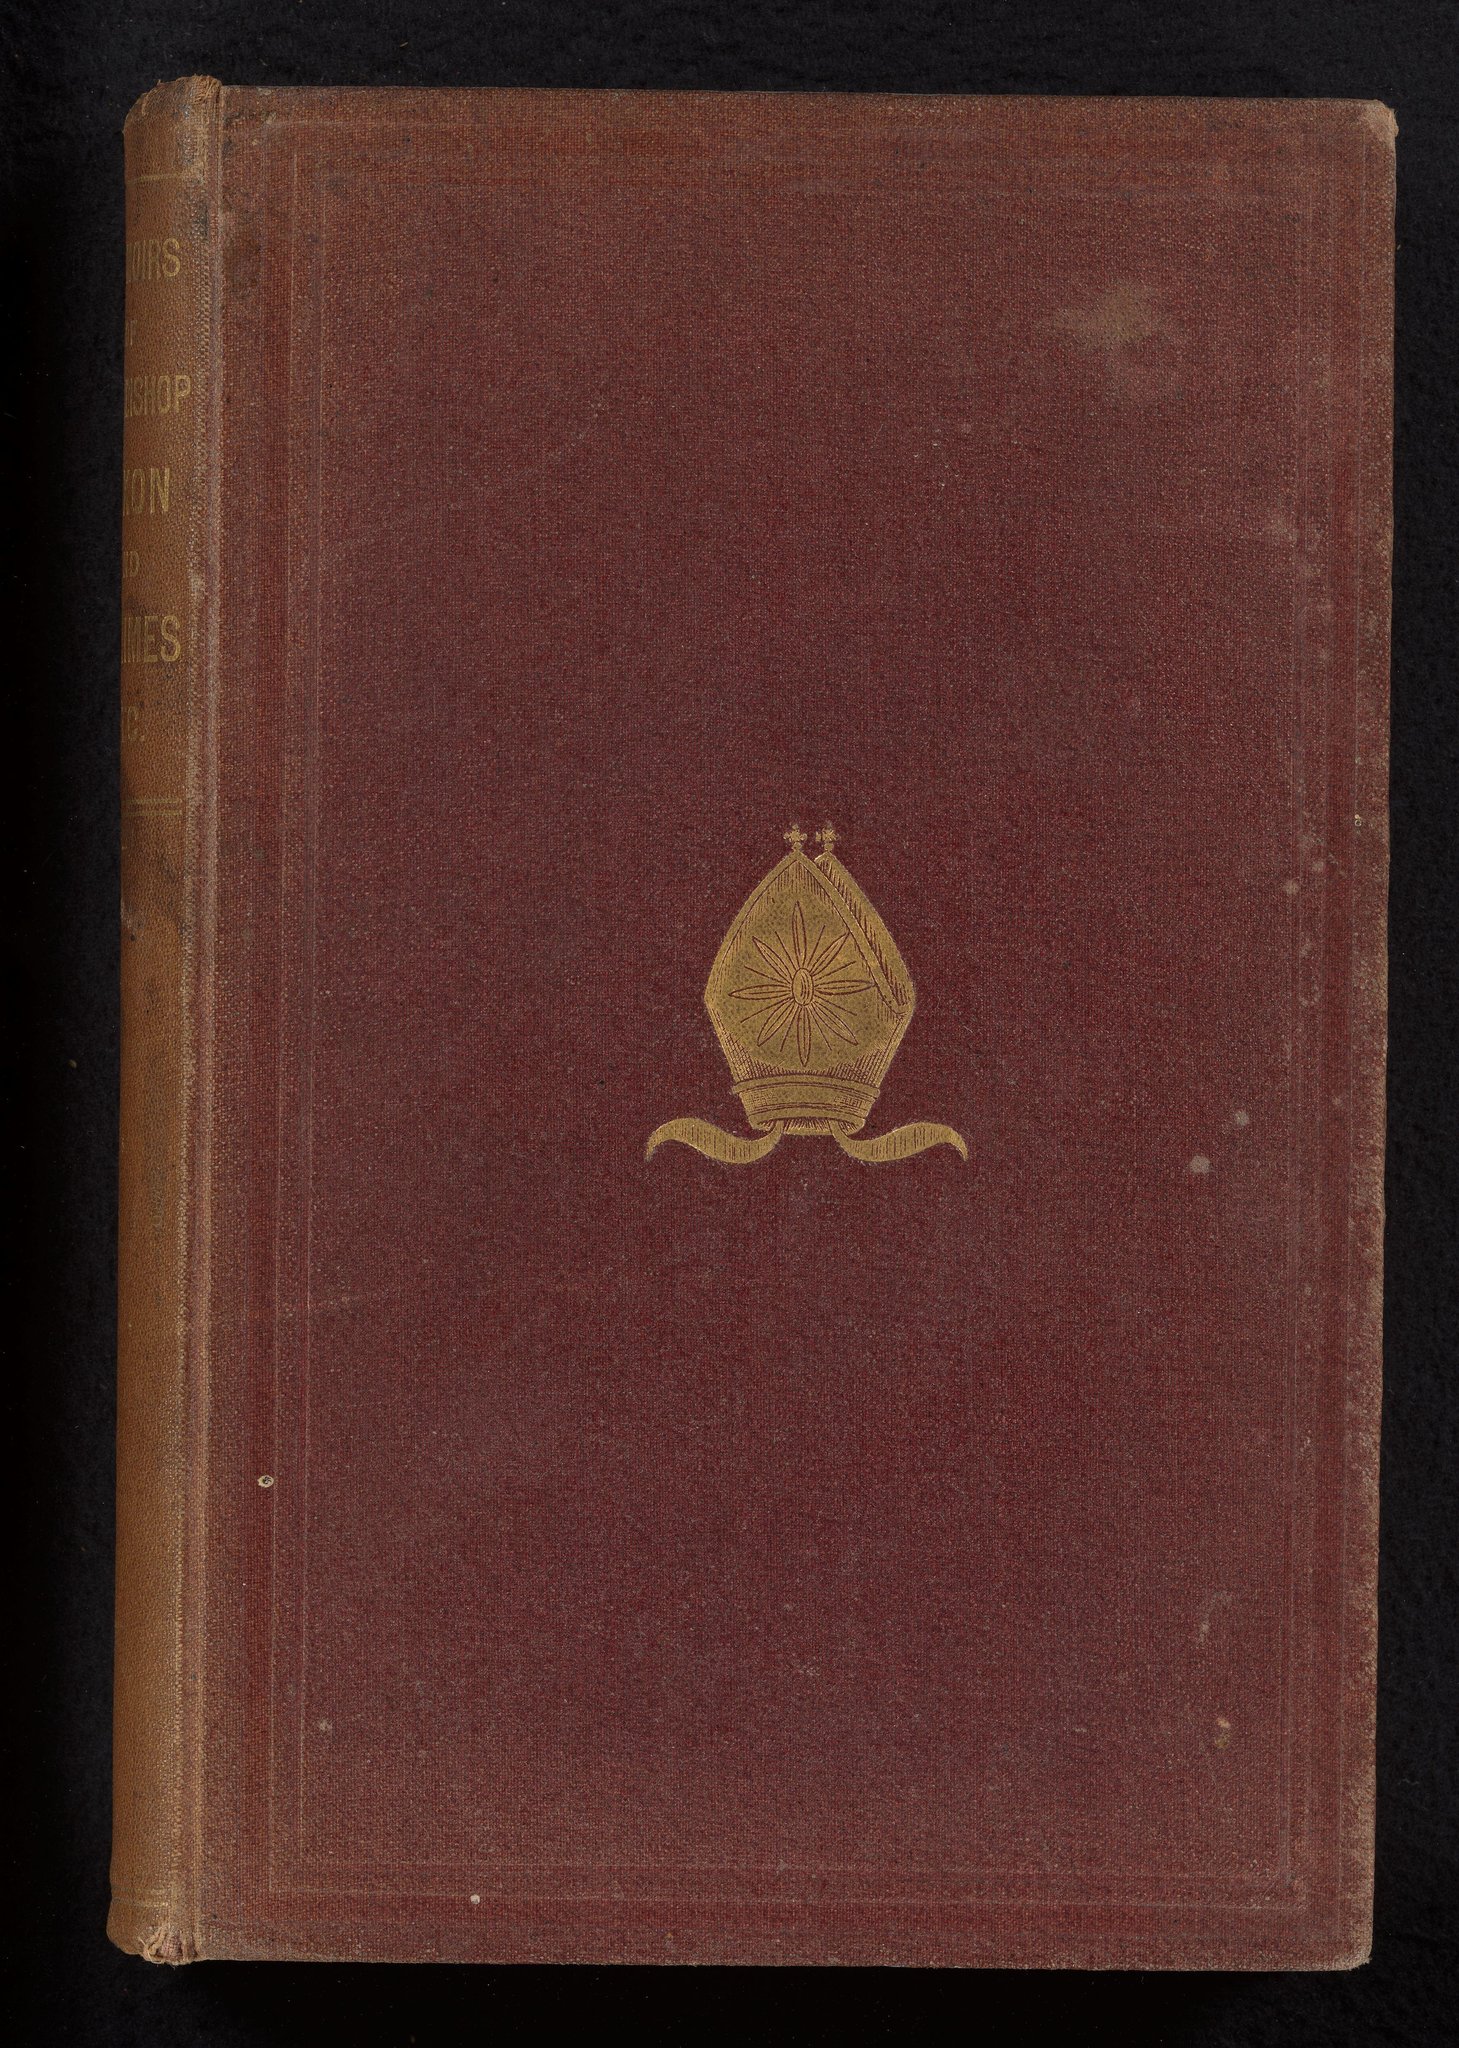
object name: book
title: Memoirs of archbishop Juxon and his times : with a sketch of the archbishop's parish Little Compton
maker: william hennessey marah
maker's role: predikant, schrijver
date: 1869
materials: cardboard, linen, paper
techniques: albumen print, letterpress printing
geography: oxford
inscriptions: inscription: ‘Bilder/ H[?]/ from/ AB’